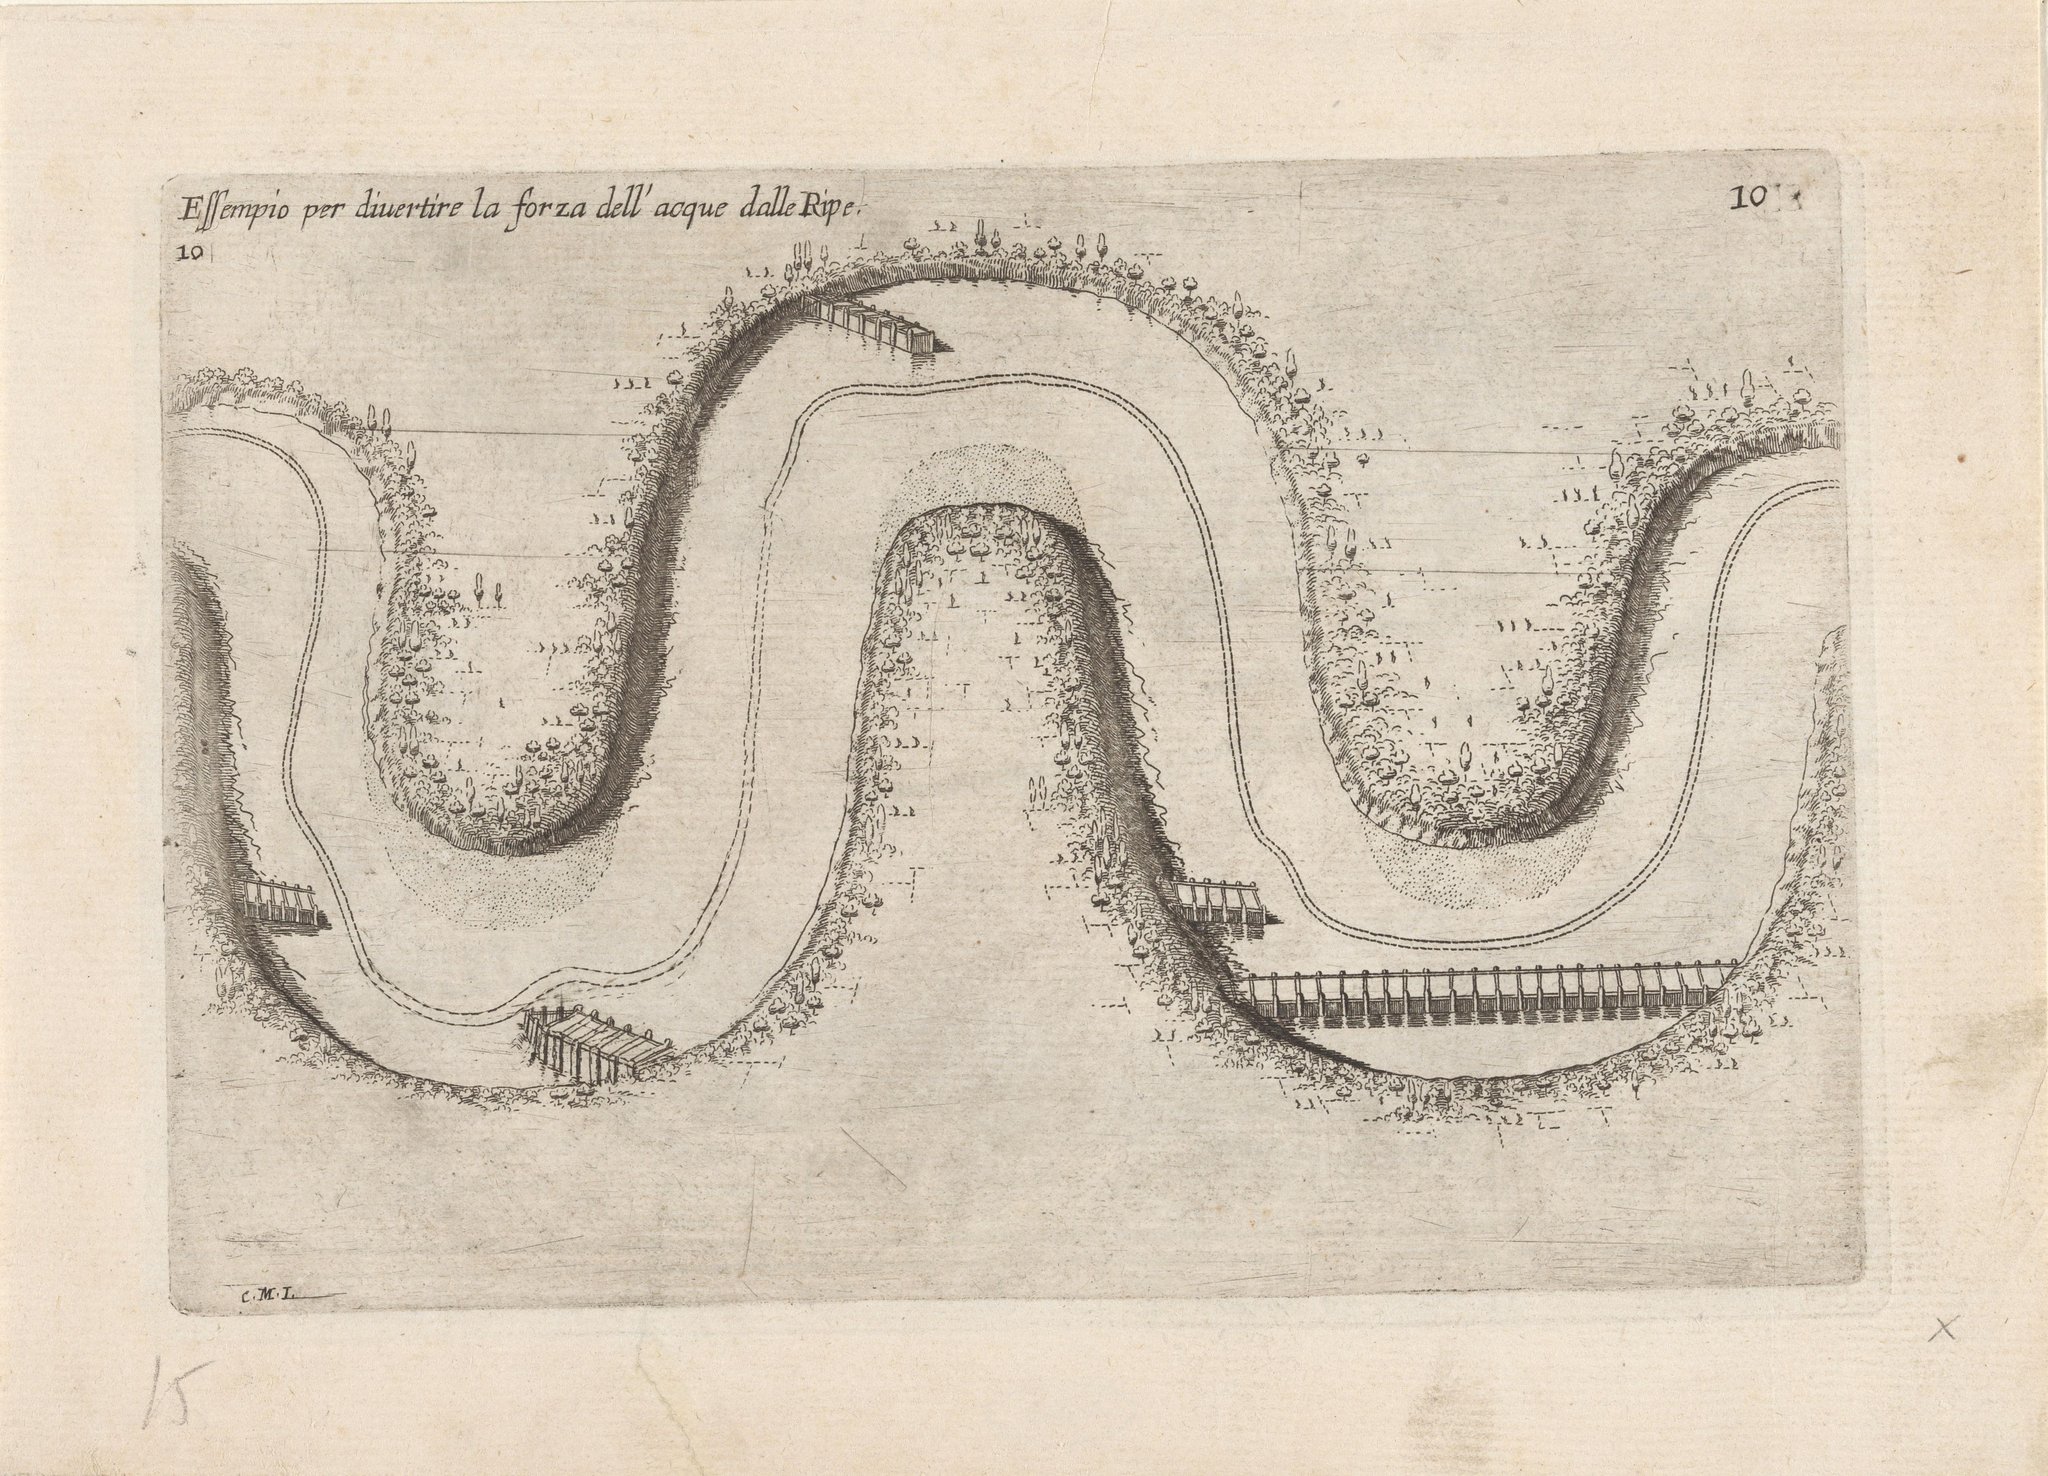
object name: print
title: L'arte di rendere i fiumi navigabili, in varij modi, con altre nuove inventioni, e varij altri segreti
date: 1677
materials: paper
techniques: etching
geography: rome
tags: river, dam (in canal)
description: Deze prent maakte oorspronkelijk deel uit van een publicatie bestaande uit drie delen, uitgegeven door G.G. Komarek in Rome in 1696. Het eerste deel zit achter een titelpagina met de titel: L'arte di rendere i fiumi navigabili, in varij modi, con altre nuove inventioni, e varij altri segreti. Deel twee zit achter een titelpagina met de titel: Racolta di varii segreti come si vedono nelle segventi figure. Deel drie zit achter een titelpagina met de titel: Osservazioni delle comete che dovranno seguire, e dell'ecclisse del primo satellite di Giove, et altre propositioni prosicue da farsi per commodo & ornamento della città. Deze prent komt uit het eerste deel. Prenten in de publicatie zijn naar ontwerp van Cornelis Meijer gemaakt door verschillende prentmakers, onder wie G.B. Falda, G. van Wittel, Gomar Wouters, etc. Er is ook een eerdere versie bekend van deze publicatie, uitgegeven in Rome in 1683, met de titel: L'arte di restituire a Roma la tralasciata navigazione del suo Tevere.